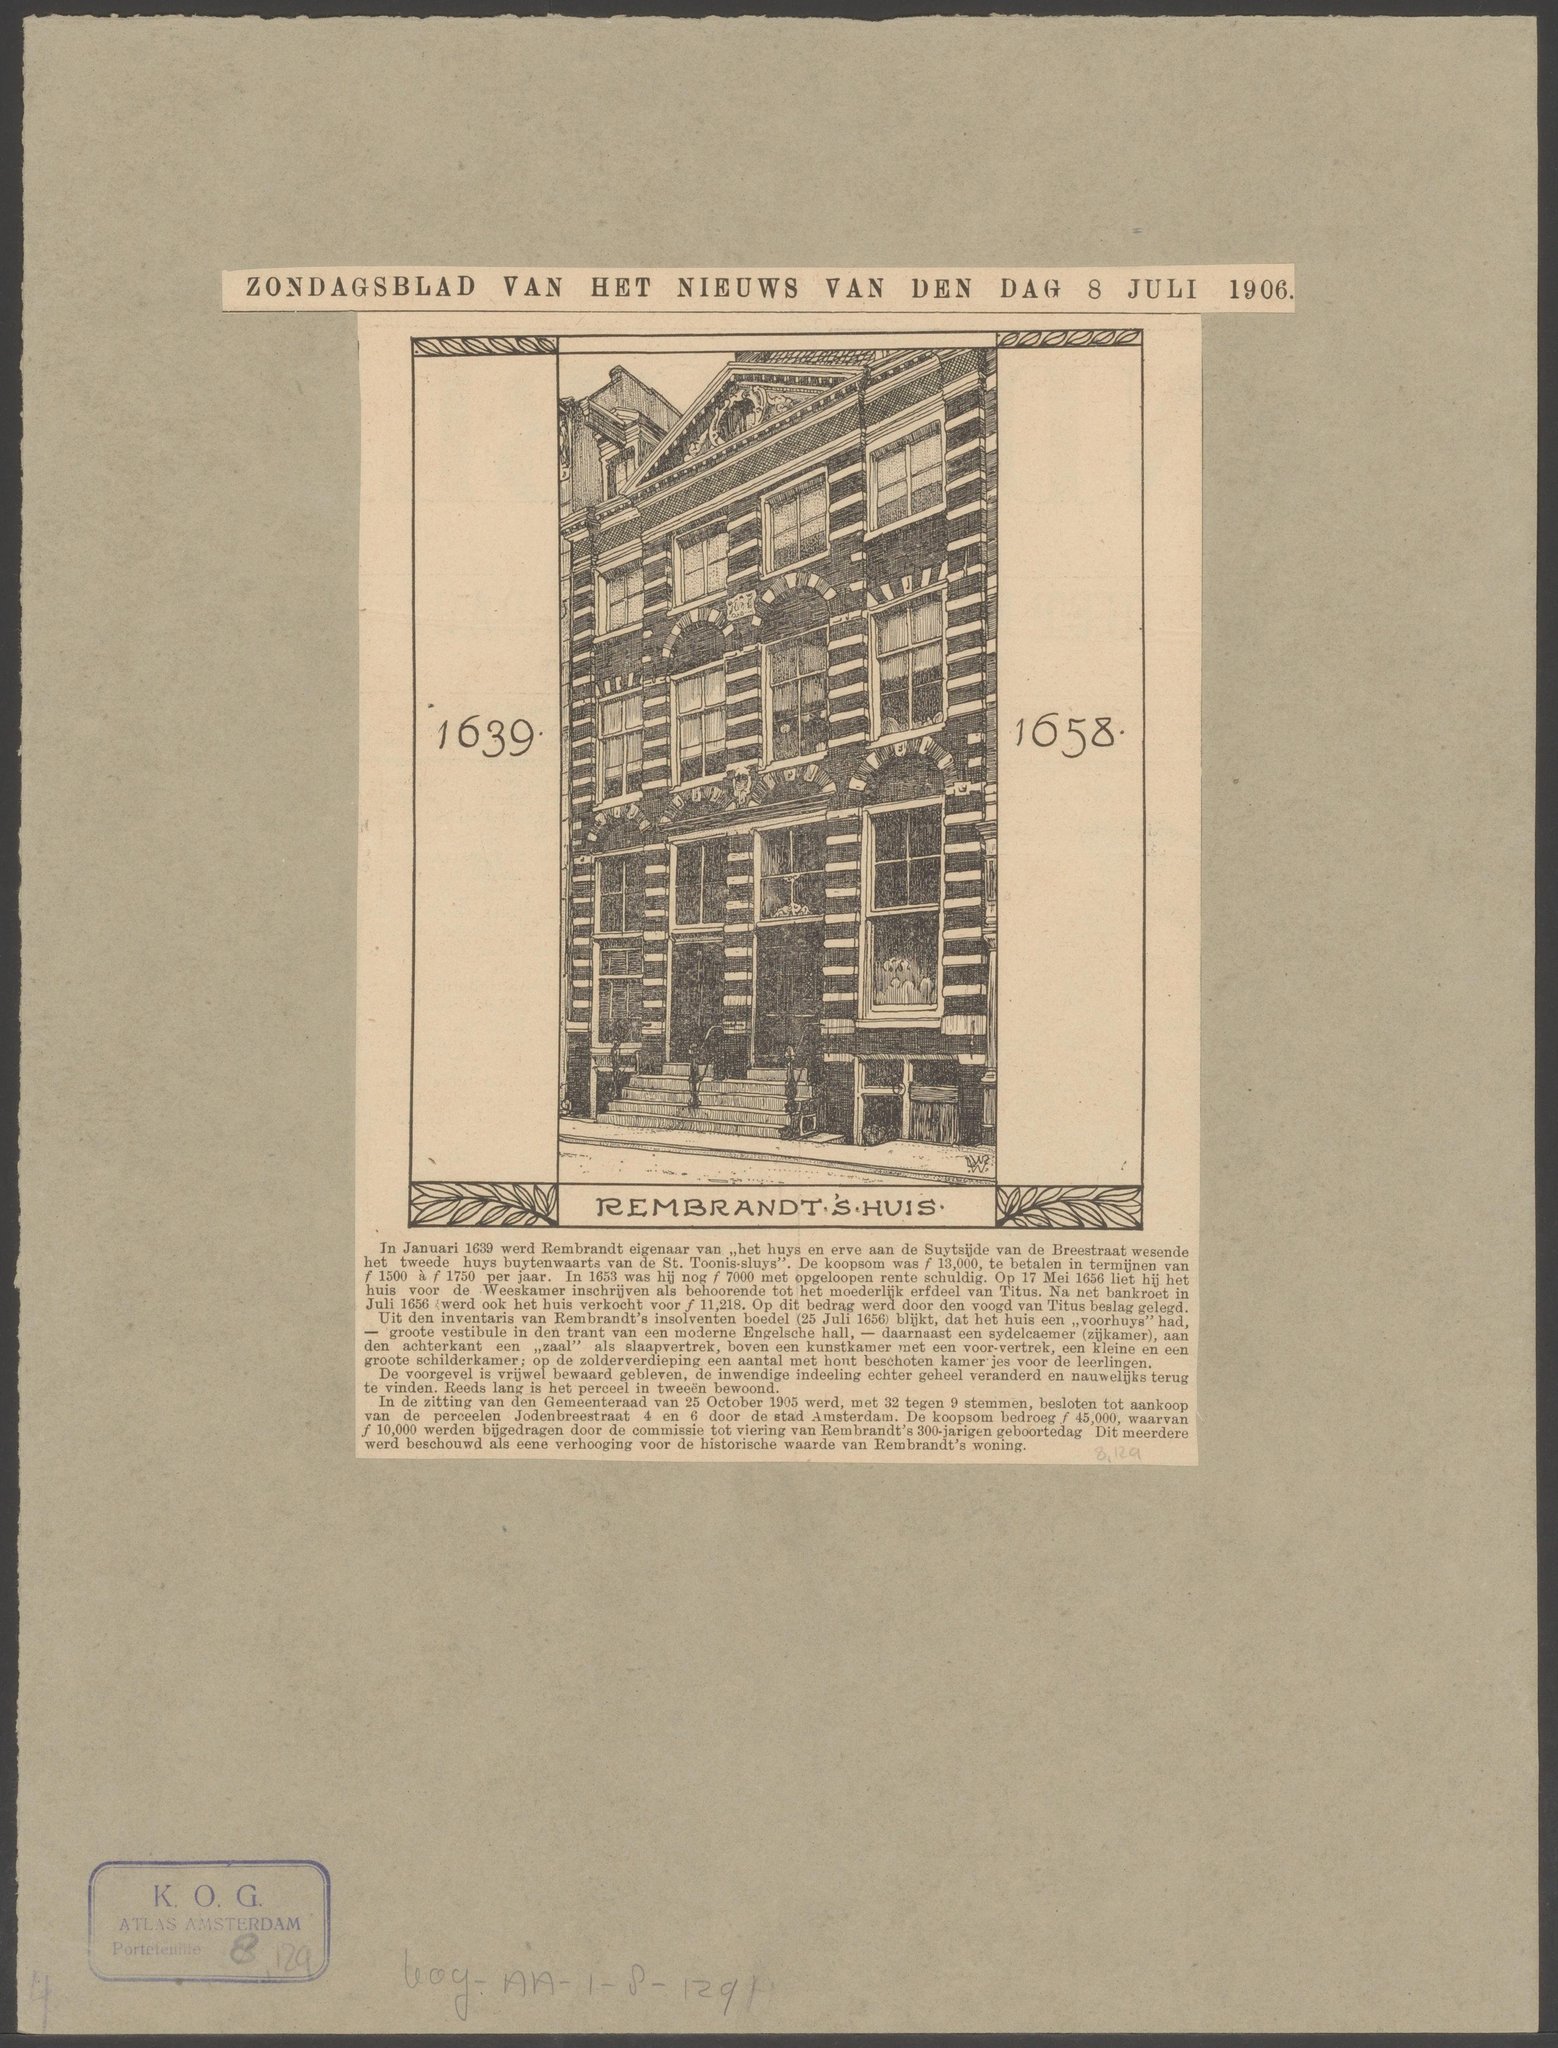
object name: photomechanical print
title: Gezicht op het huis van Rembrandt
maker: willem wenckebach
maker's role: designer, draughtsman, painter, print maker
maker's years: 1860-1937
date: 1906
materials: paper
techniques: letterpress printing, line block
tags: city-view in general; 'veduta', façade (of house or building)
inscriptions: collector's mark: ‘8,129’ Lugt 1641b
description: Onderwerpsrubriek binnen de Atlas Amsterdam: Jacobszstraat (Pieter), Jodenbreestraat, Jodenhoek, Jonge Roelensteeg, Jonker- en Ridderstraat.